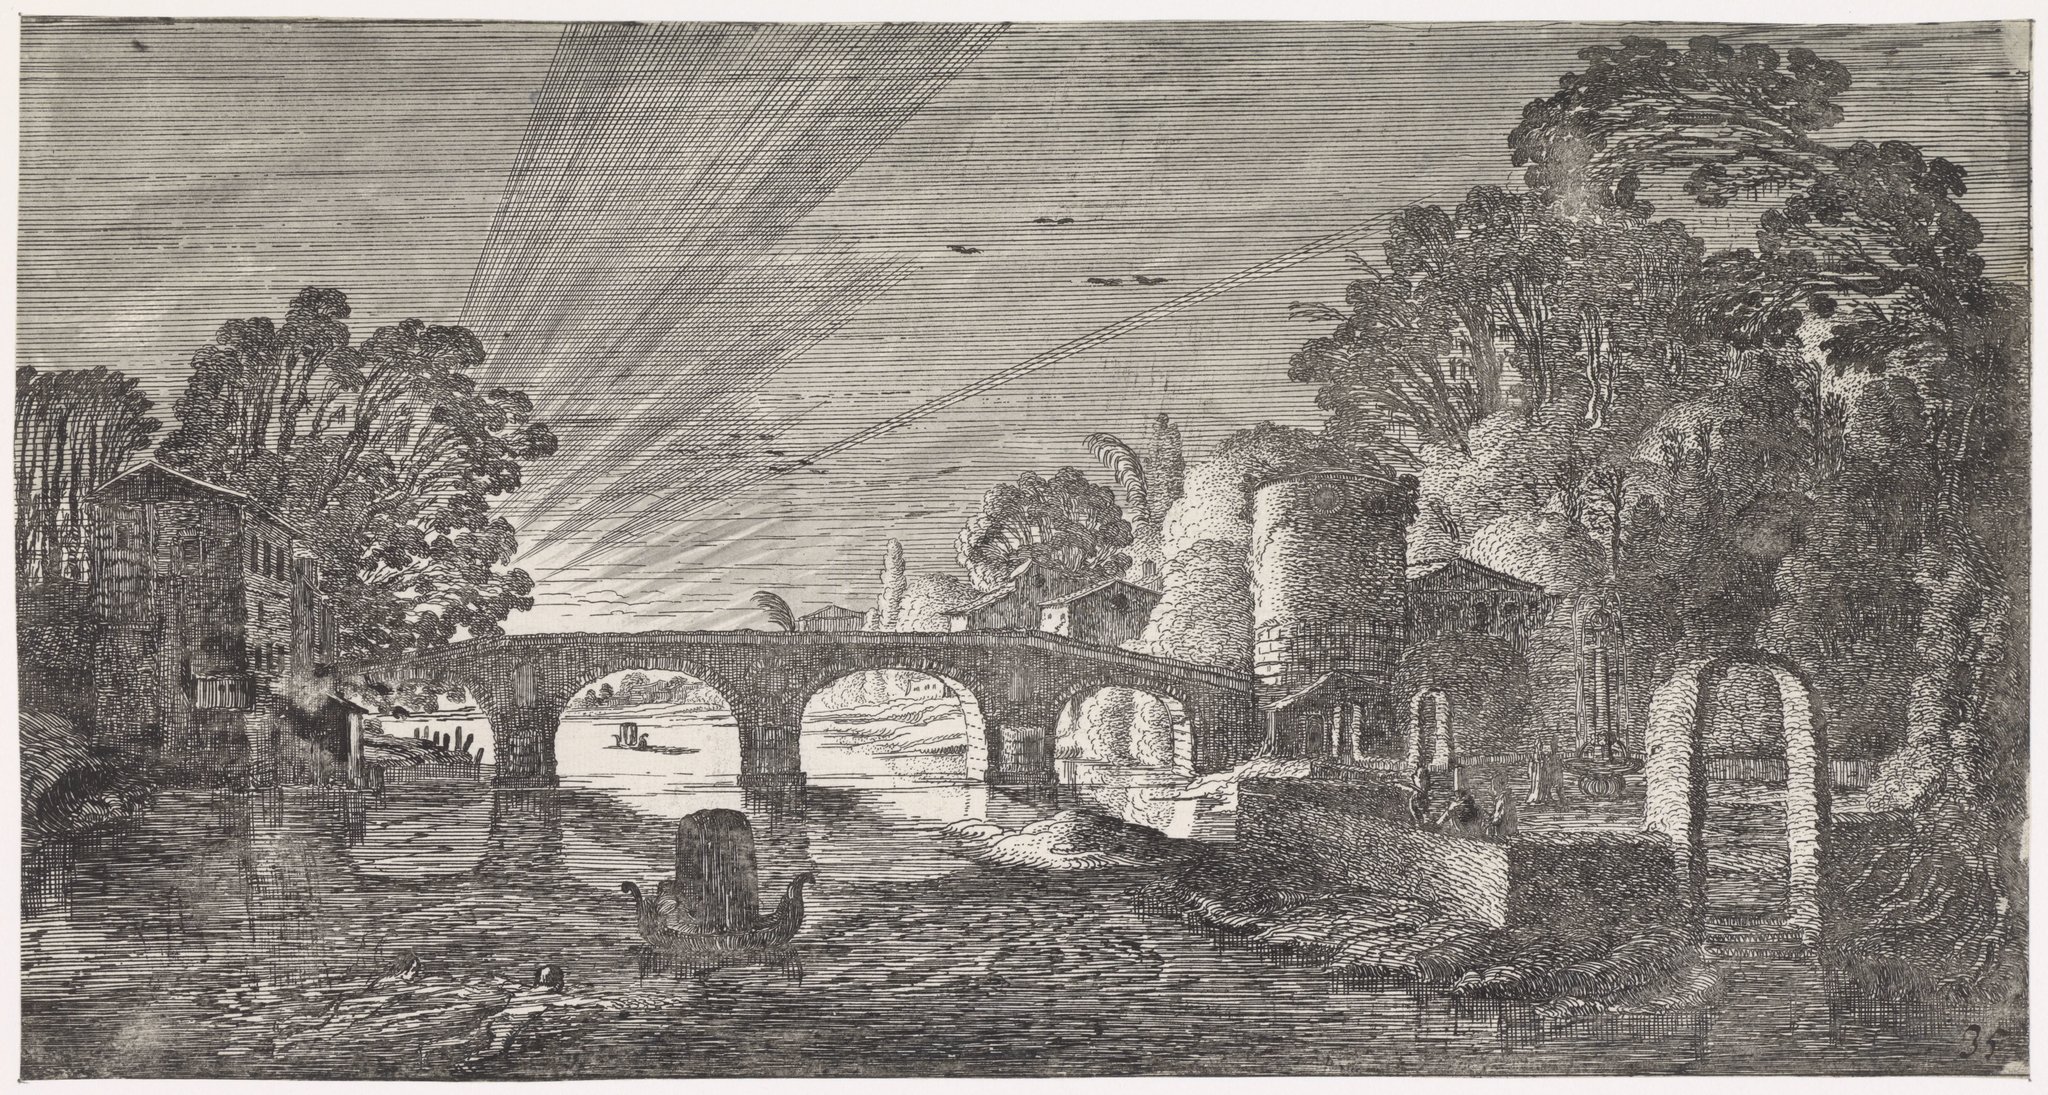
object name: print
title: Riviergezicht bij zonsondergang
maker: jan van de velde (ii)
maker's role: draughtsman, painter, print maker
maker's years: 1593-1641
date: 1639-1641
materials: ink, paper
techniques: brush, engraving, etching, pen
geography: northern netherlands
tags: dusk, evening twilight, river, landscape with bridge, viaduct or aqueduct, sunset, bridge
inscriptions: collector's mark: Lugt 2228, collector's mark: Lugt 1120, number: ‘35’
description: Riviergezicht bij zondondergang. In het midden een stenen brug. Links twee zwemmende figuren en rechts converserende figuren in een tuin. 35ste prent van een serie met 36 prenten van landschappen, verdeeld over zes delen.